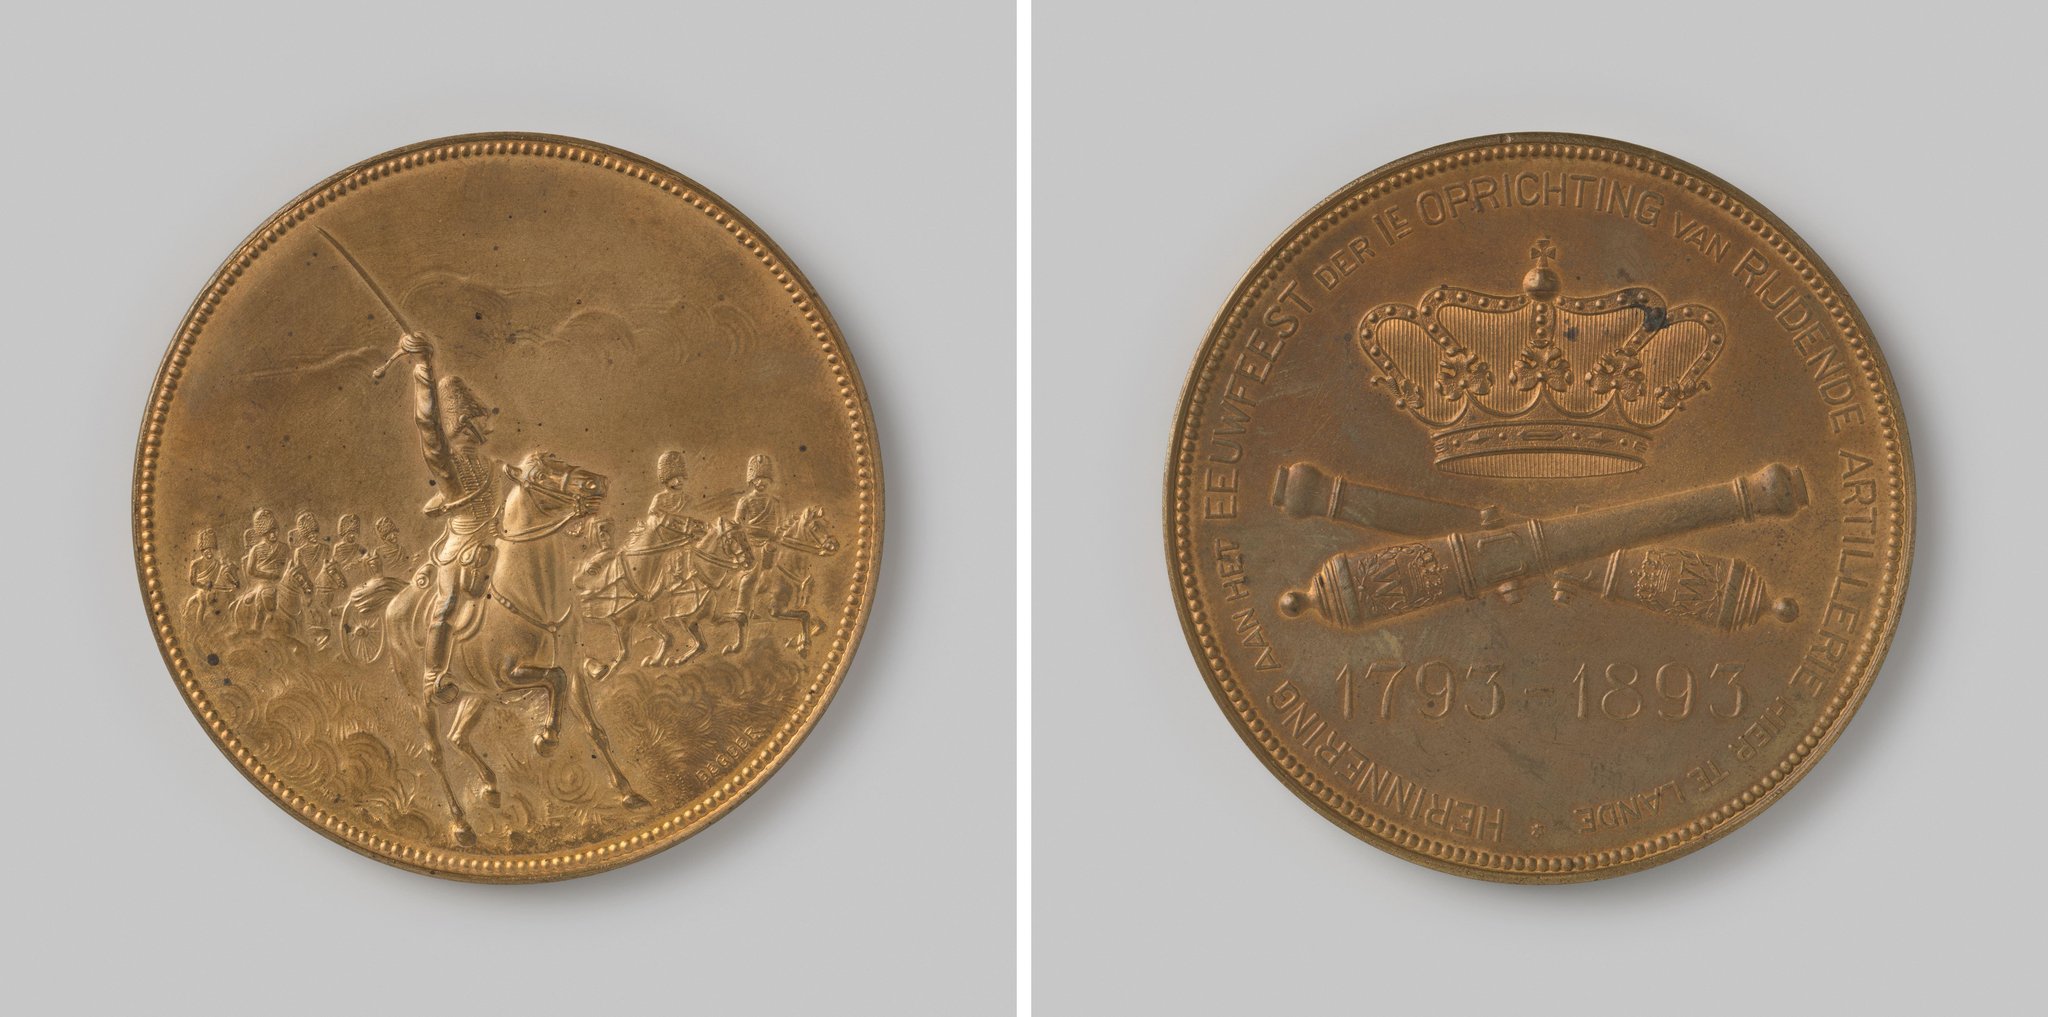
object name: history medal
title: Honderdjarig bestaan van de Rijdende Artillerie 1893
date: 1893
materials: brass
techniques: striking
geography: utrecht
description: Vergulde penning, op de voorzijde een groep rijdende artillerie te velde met aanvoerder op de voorgrond, op de keerzijde twee kanonslopen onder een kroon boven twee jaartallen, met omschrift.